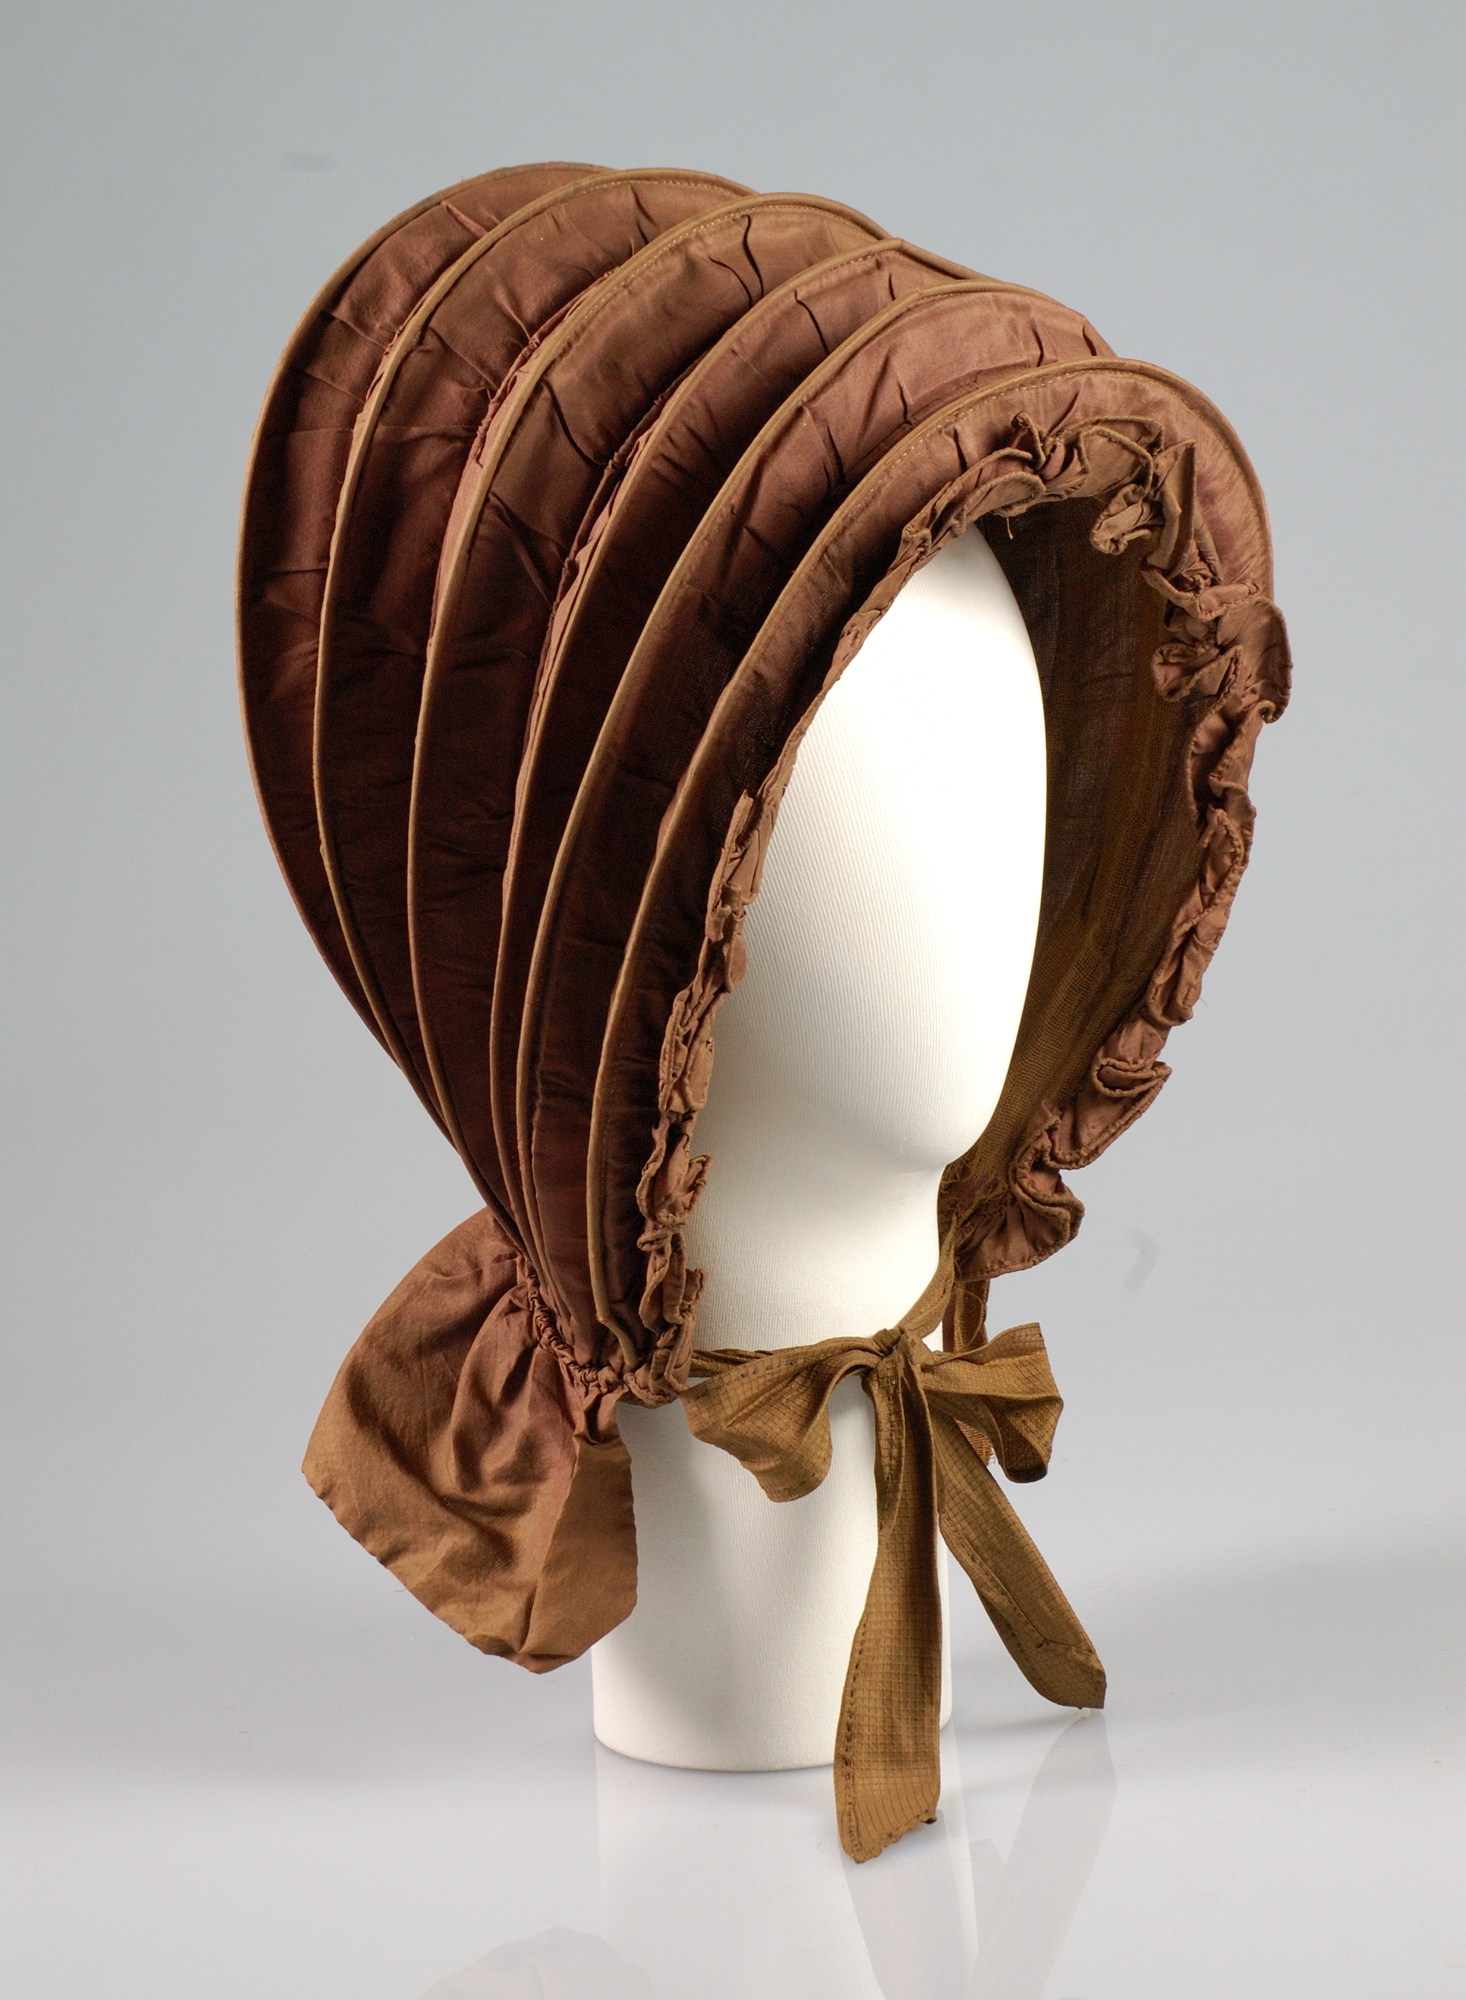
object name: calash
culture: american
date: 1830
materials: silk